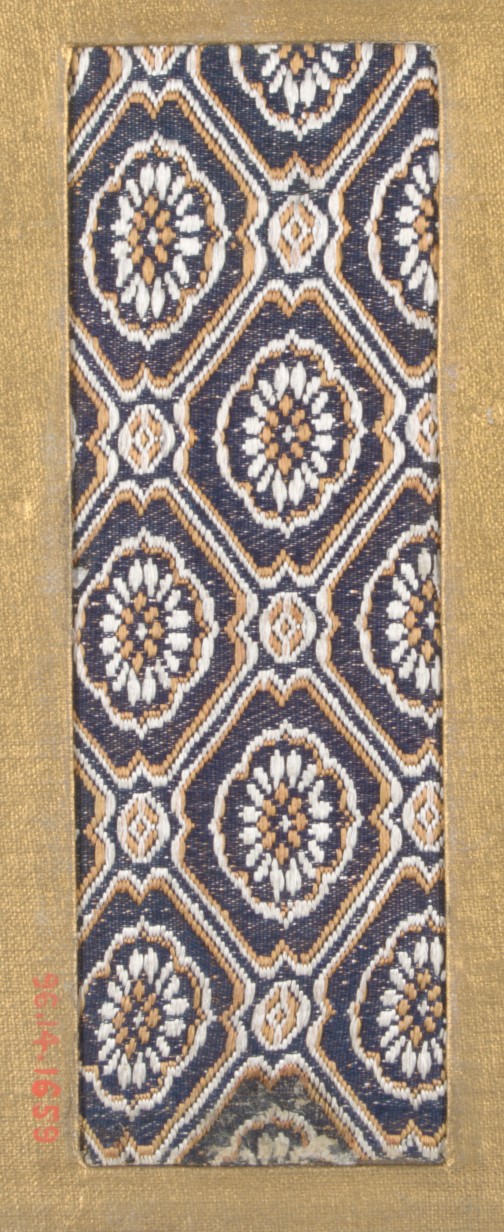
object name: piece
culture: japanese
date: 1701-1900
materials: silk